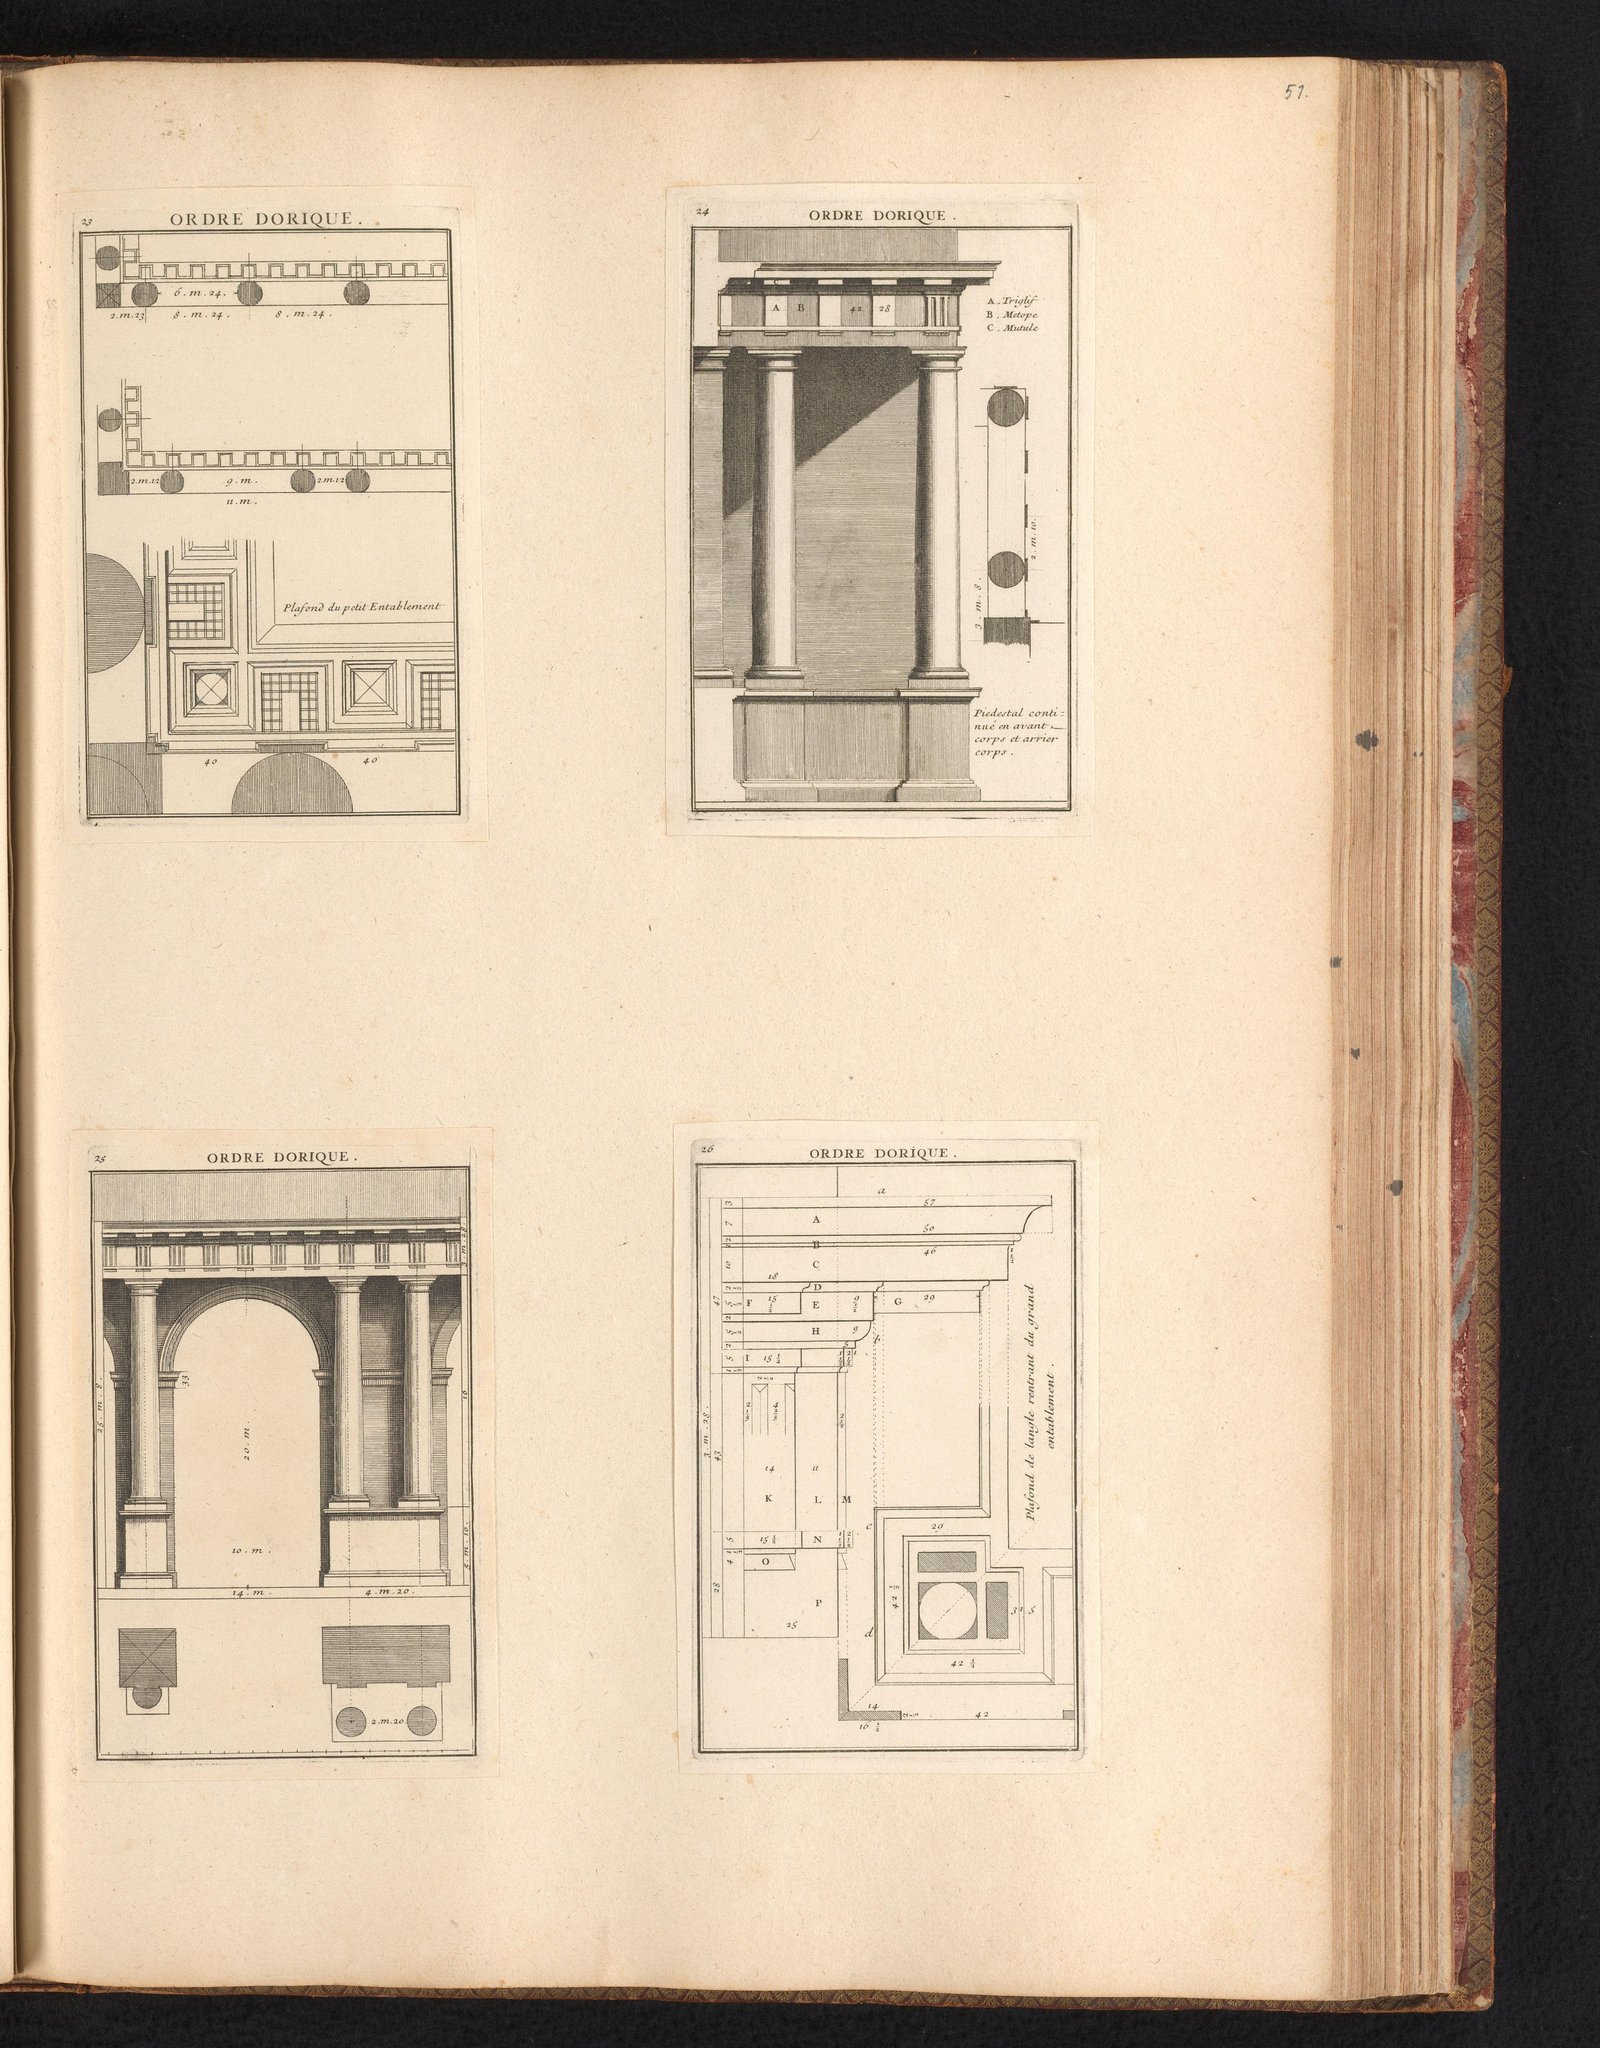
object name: album leaf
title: Zuilen van de Dorische orde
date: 1714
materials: paper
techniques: etching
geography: paris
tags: doric order ~ architecture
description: Prenten uit: Leclerc, Sébastien (I). Traité d'architecture. Parijs: Pierre François Giffart, 1714.